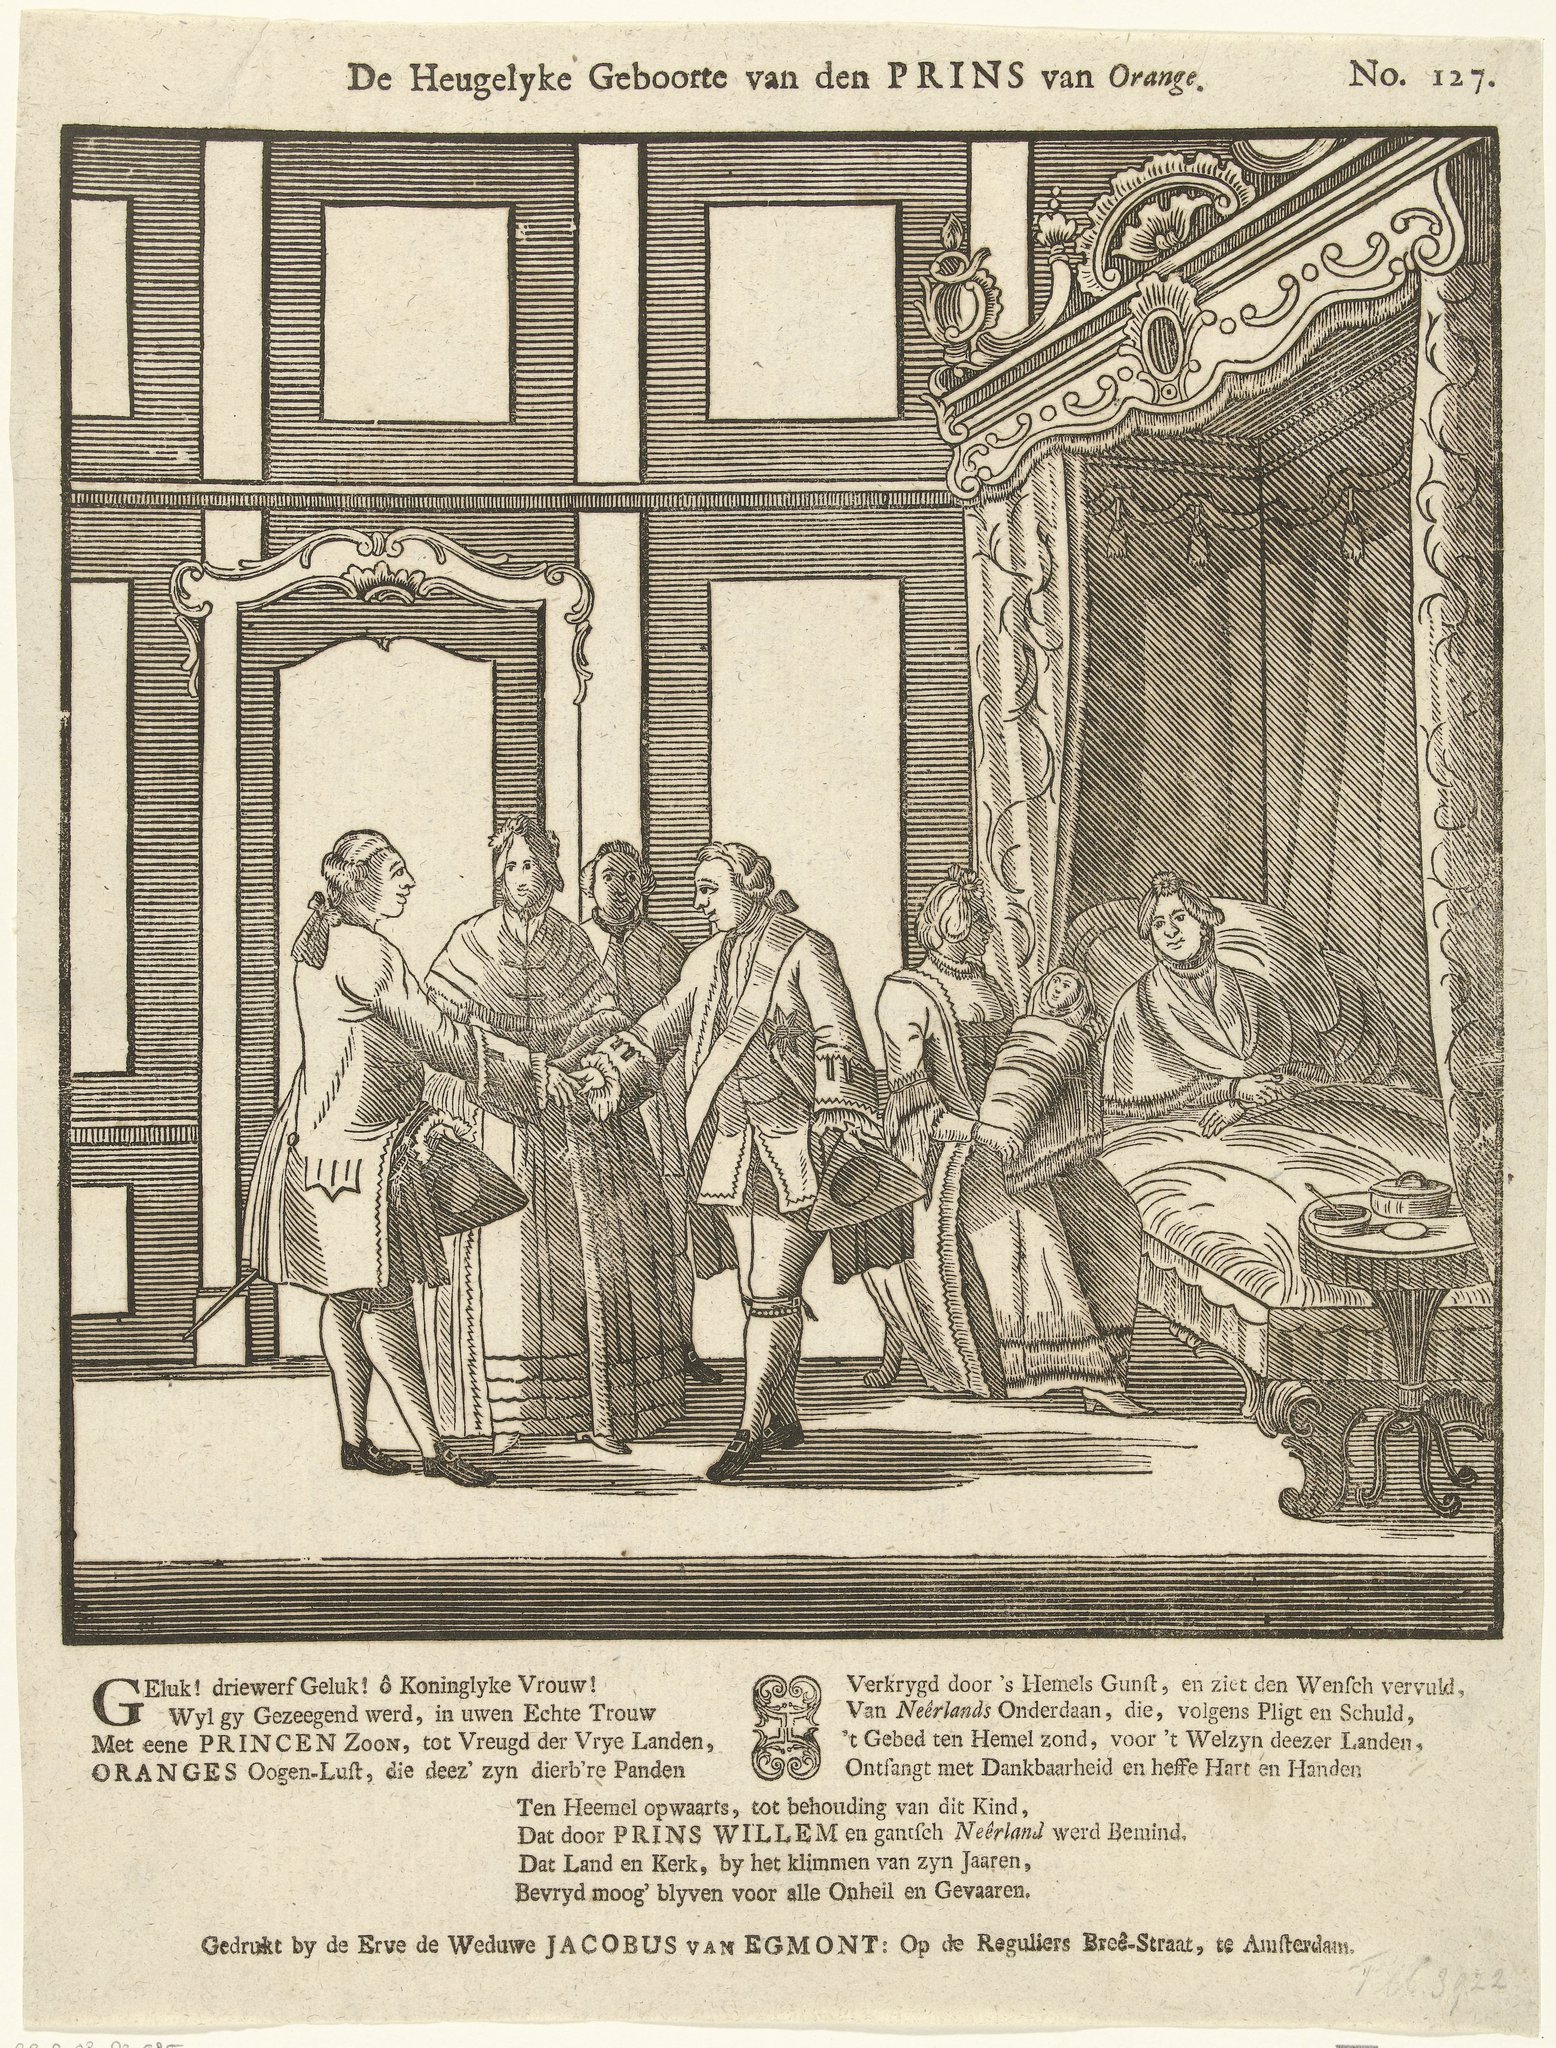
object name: popular print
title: De Heugelyke Geboorte van den Prins van Orange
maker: Anonymous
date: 1761-1804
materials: paper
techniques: letterpress printing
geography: amsterdam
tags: the hague, william v (prince of orange), william i of the netherlands, berlin, painter, draughtsman, wilhelmina of prussia (princess of orange), visiting the new mother, lying-in visit, infant, baby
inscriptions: collector's mark: Lugt 2228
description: Blad met grote voorstelling van een slaapkamer waar zojuist (vermoedelijk) Willem I Frederik geboren is. In de ruimte wordt zijn vader Willem V gefeliciteerd en zijn moeder Wilhelmina van Pruisen ligt in bed. Onder de voorstelling een twaalfregelig vers in drie kolommen. Genummerd rechtsboven: No. 127.